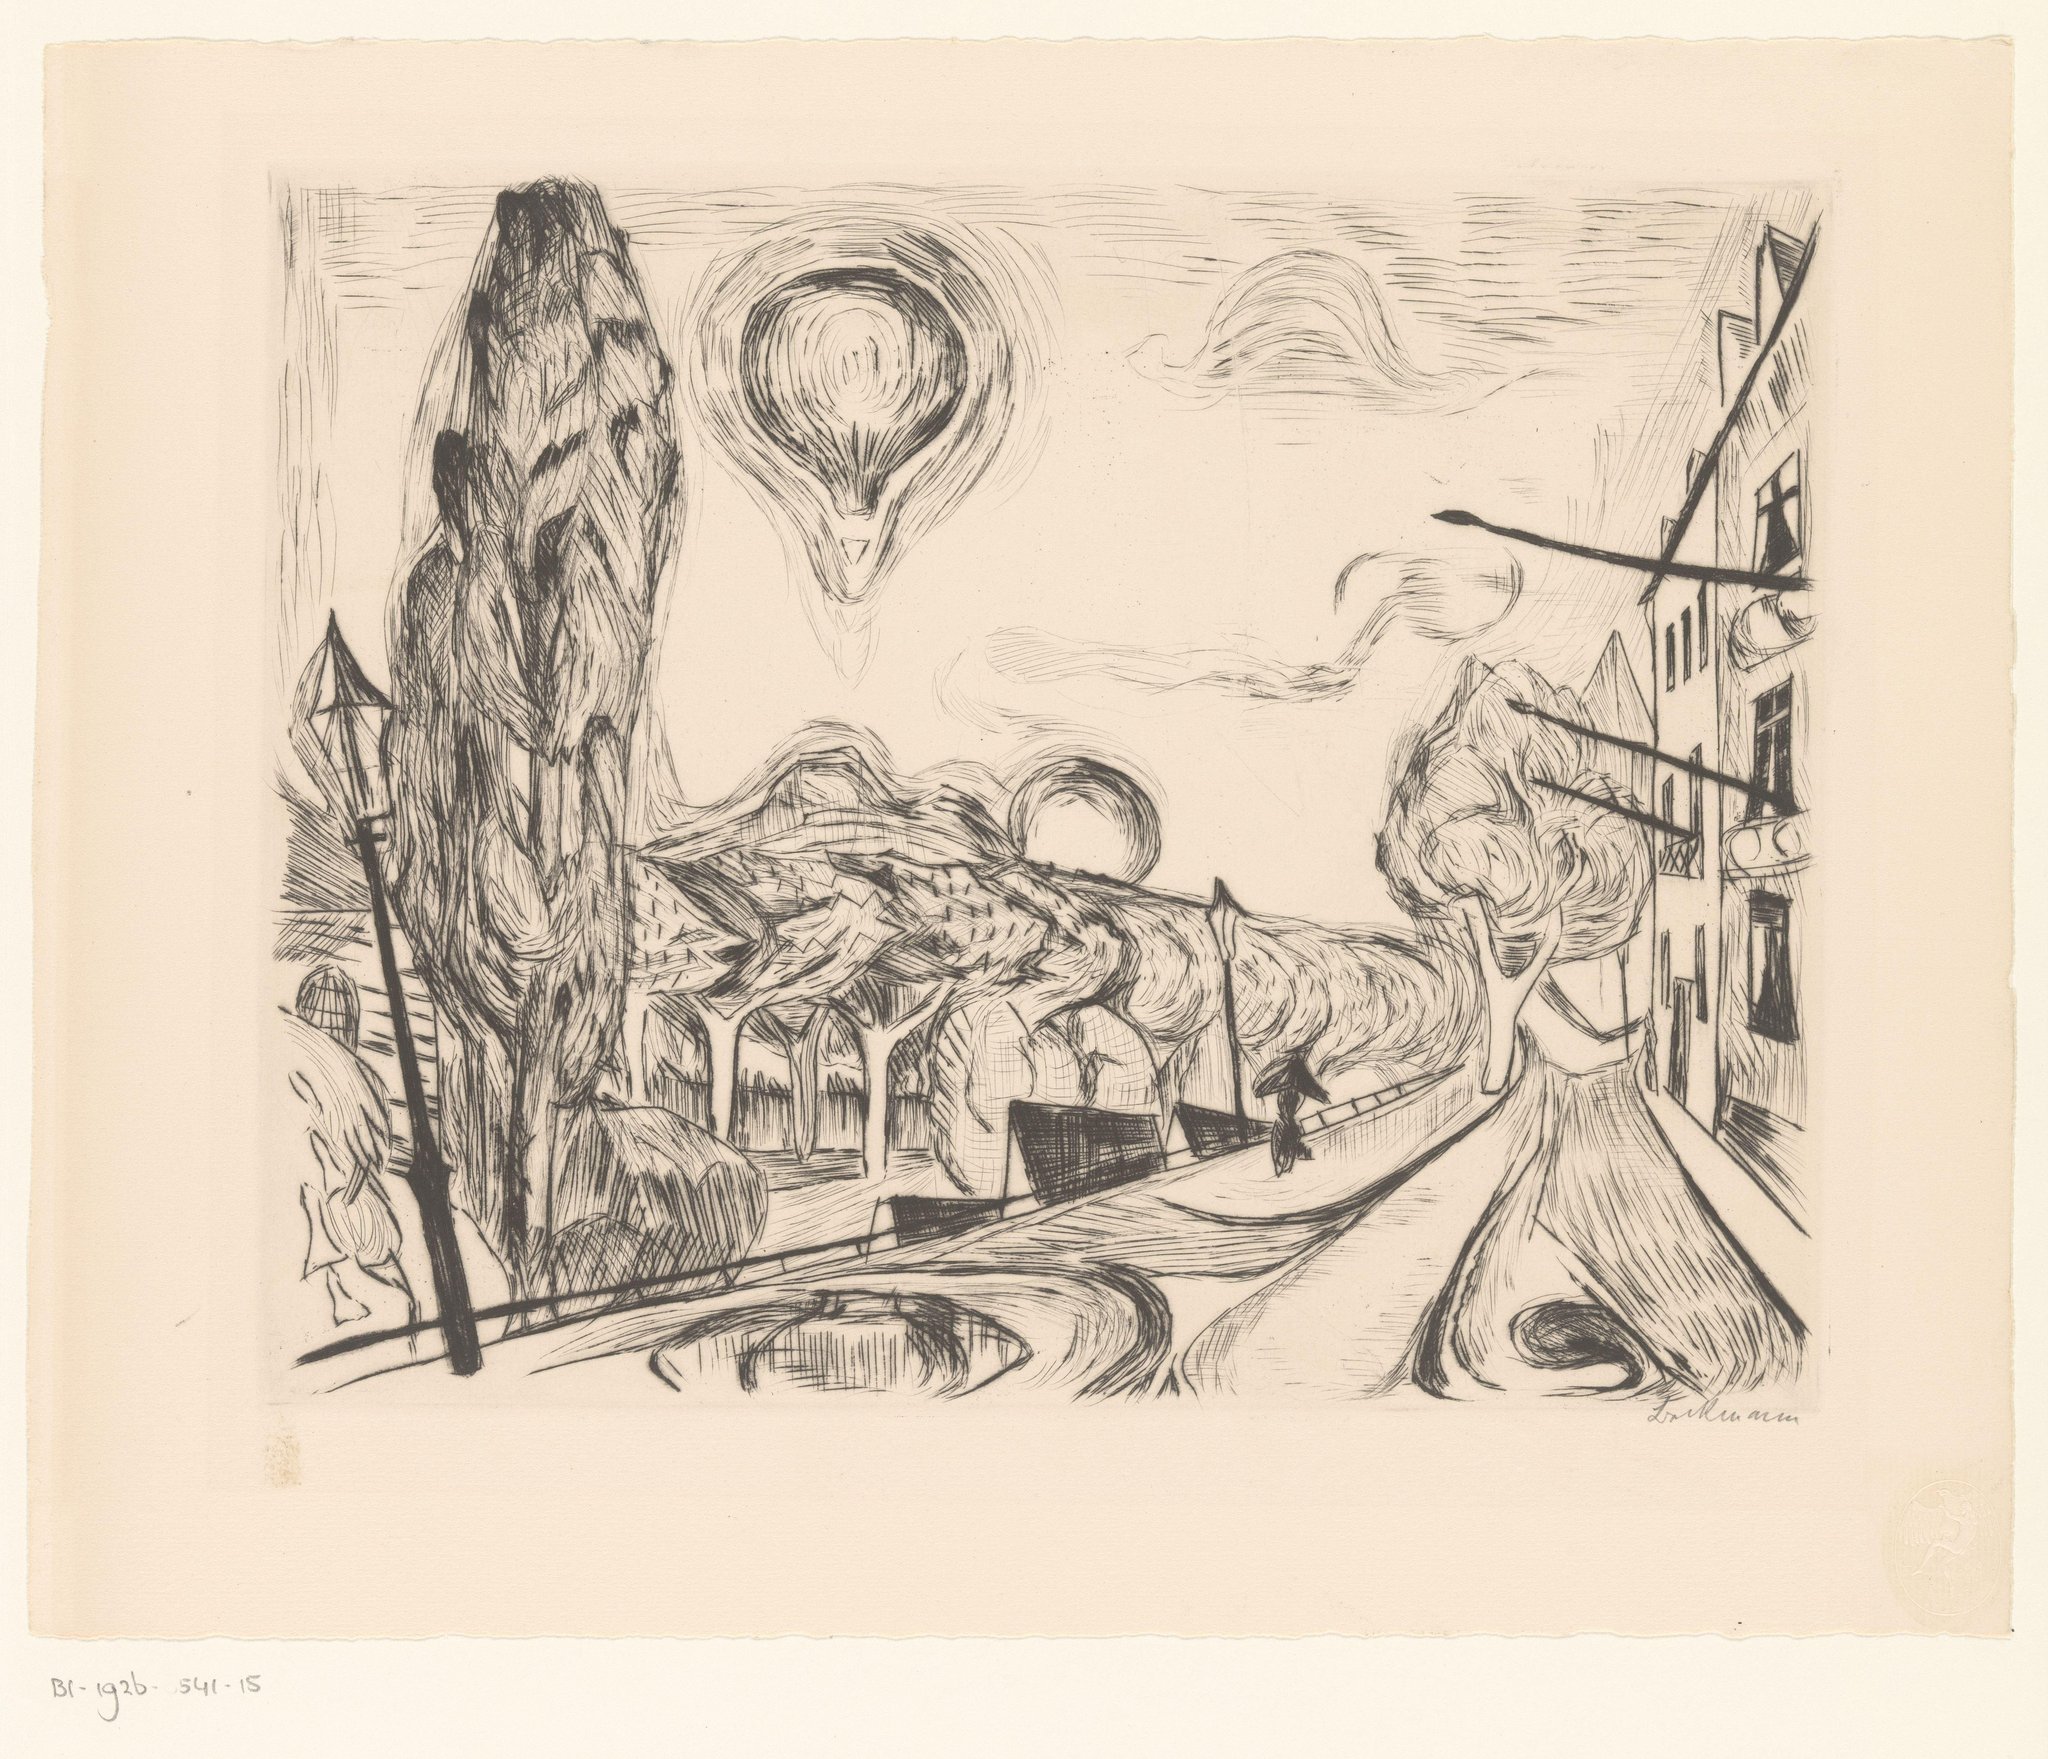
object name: print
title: Gesichten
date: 1918-1919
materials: paper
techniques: drypoint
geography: munich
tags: balloon (aviation), street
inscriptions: collector's mark: Lugt 5629, collector's mark: Lugt 2166